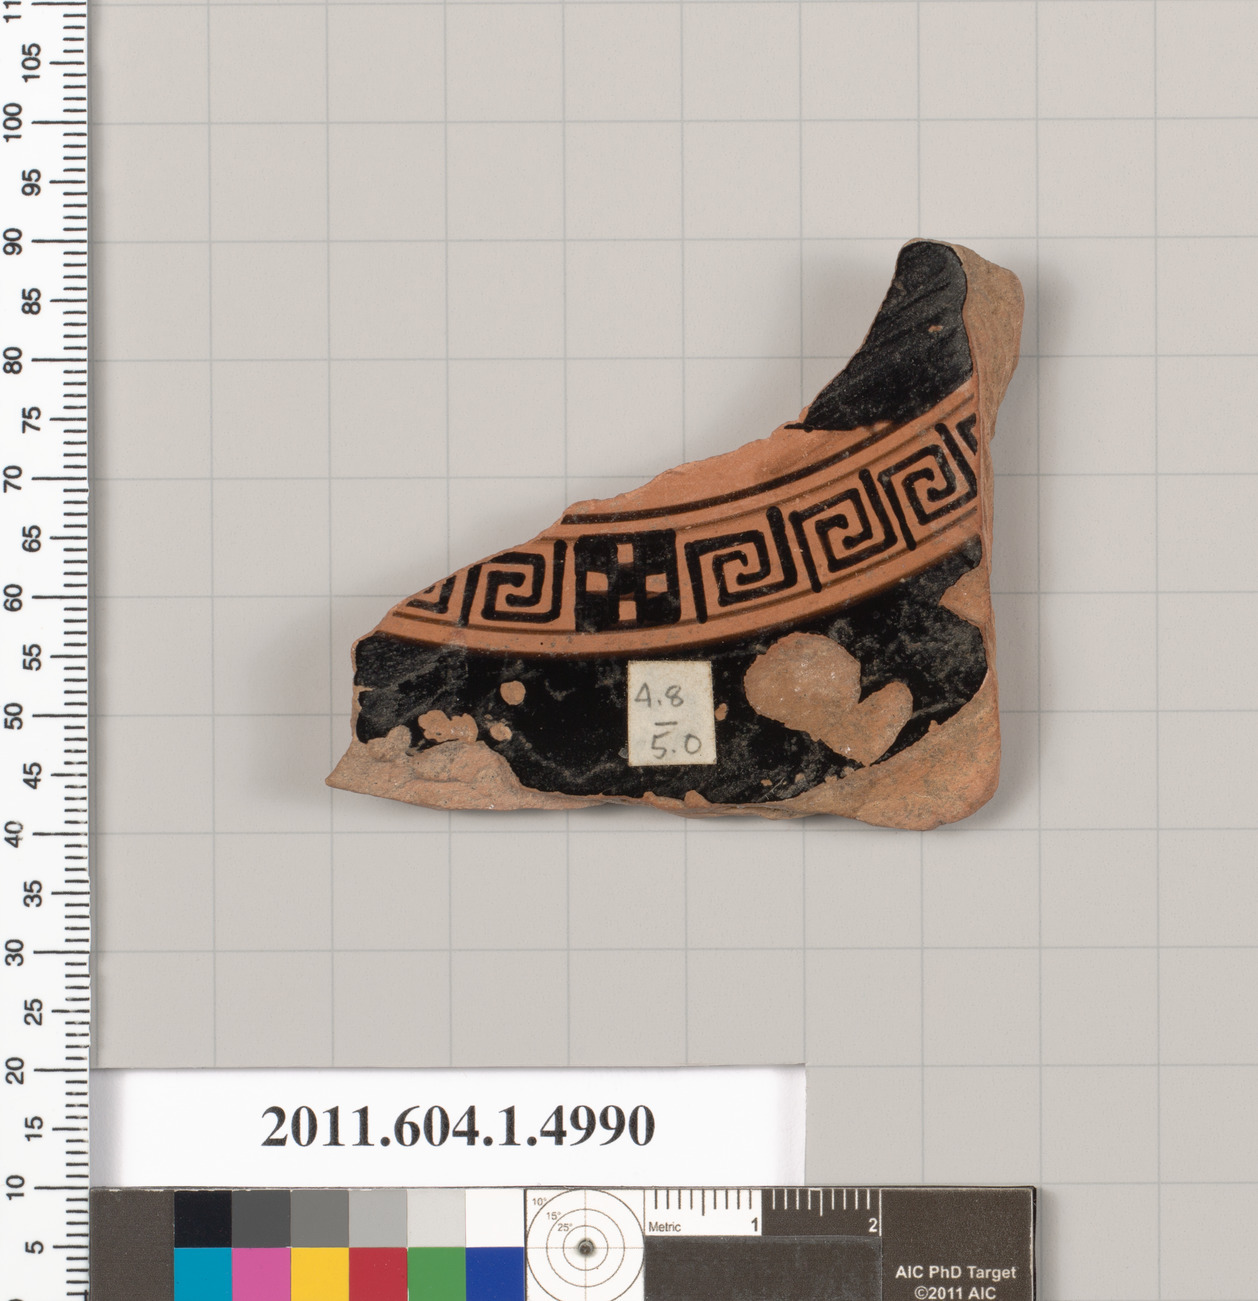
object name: kylix fragment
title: Terracotta fragment of a kylix (drinking cup)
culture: greek, attic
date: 475-451 BCE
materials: terracotta